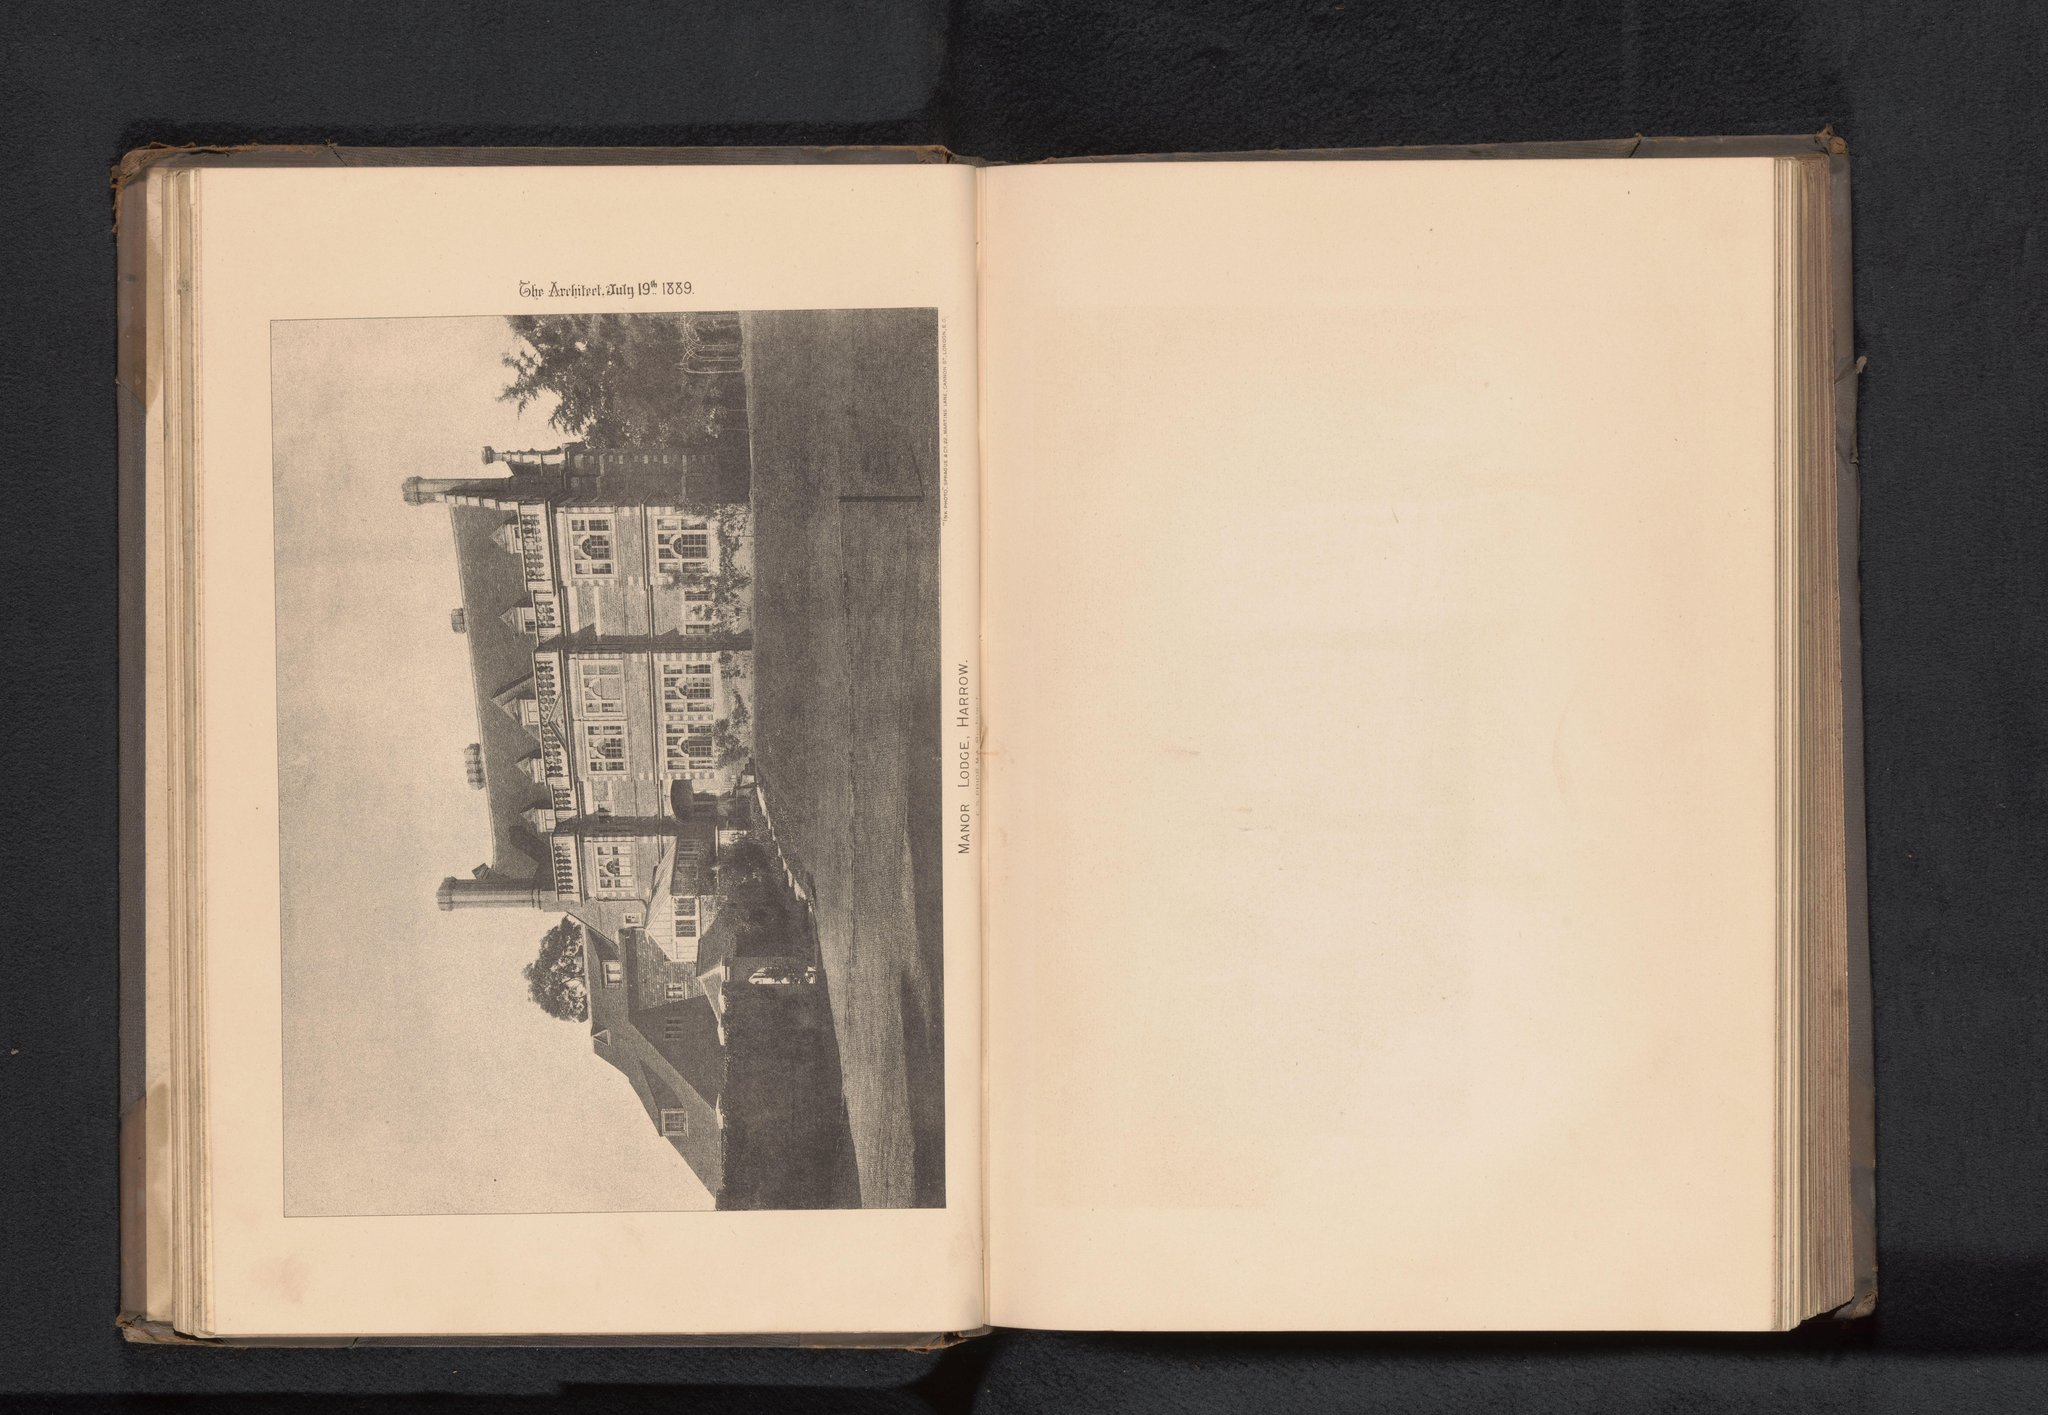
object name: page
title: Gezicht op een villa te Harrow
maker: Anonymous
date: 1884-1889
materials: paper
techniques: photolithography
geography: harrow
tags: villa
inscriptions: inscription: ‘E.S. Prior M.A. Architect/ The Architectural Illustration Society. Second Series Plate No.127’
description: Prent op vierde ongenummerde pagina na pagina 34.